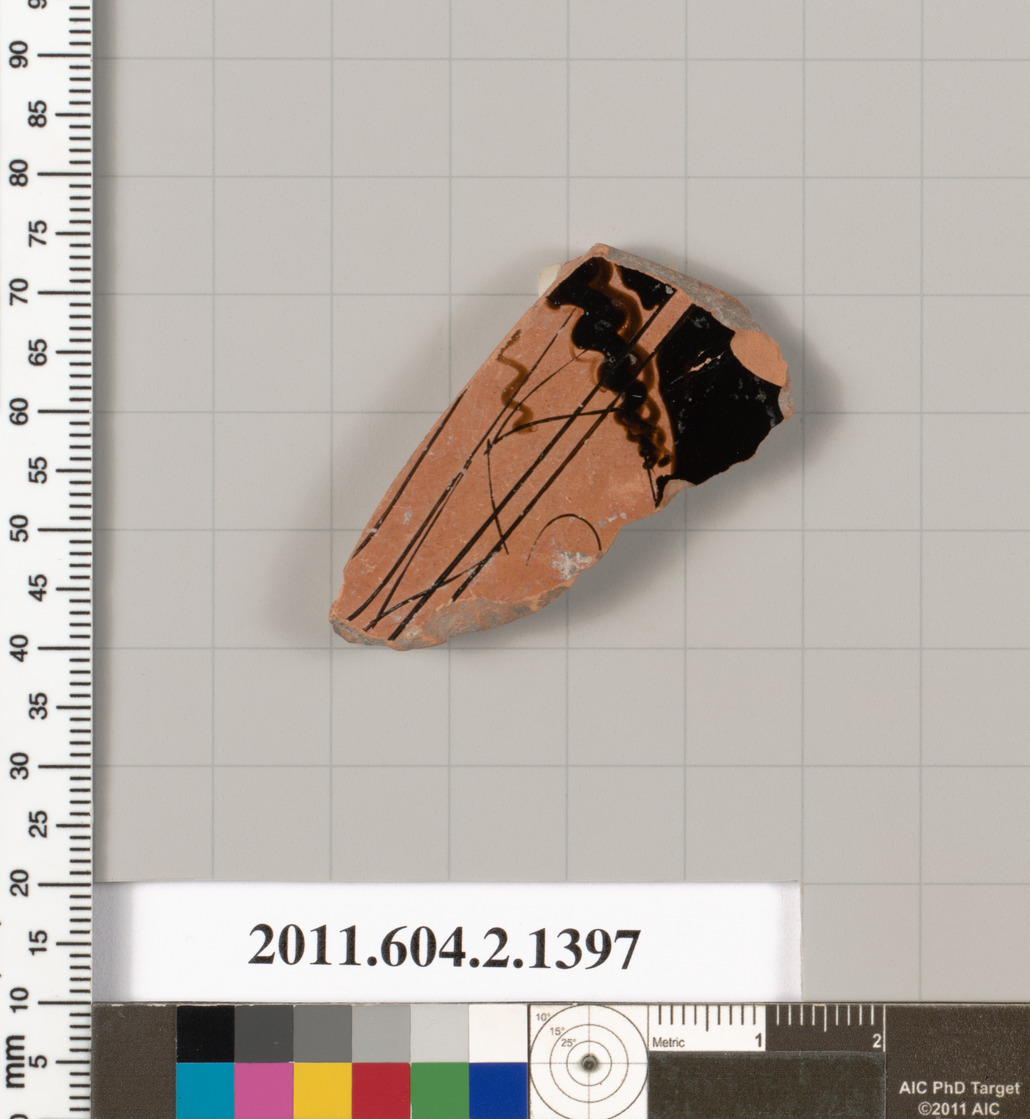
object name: skyphos fragment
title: Terracotta fragment of a skyphos (deep drinking cup)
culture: greek, attic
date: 467-435 BCE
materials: terracotta